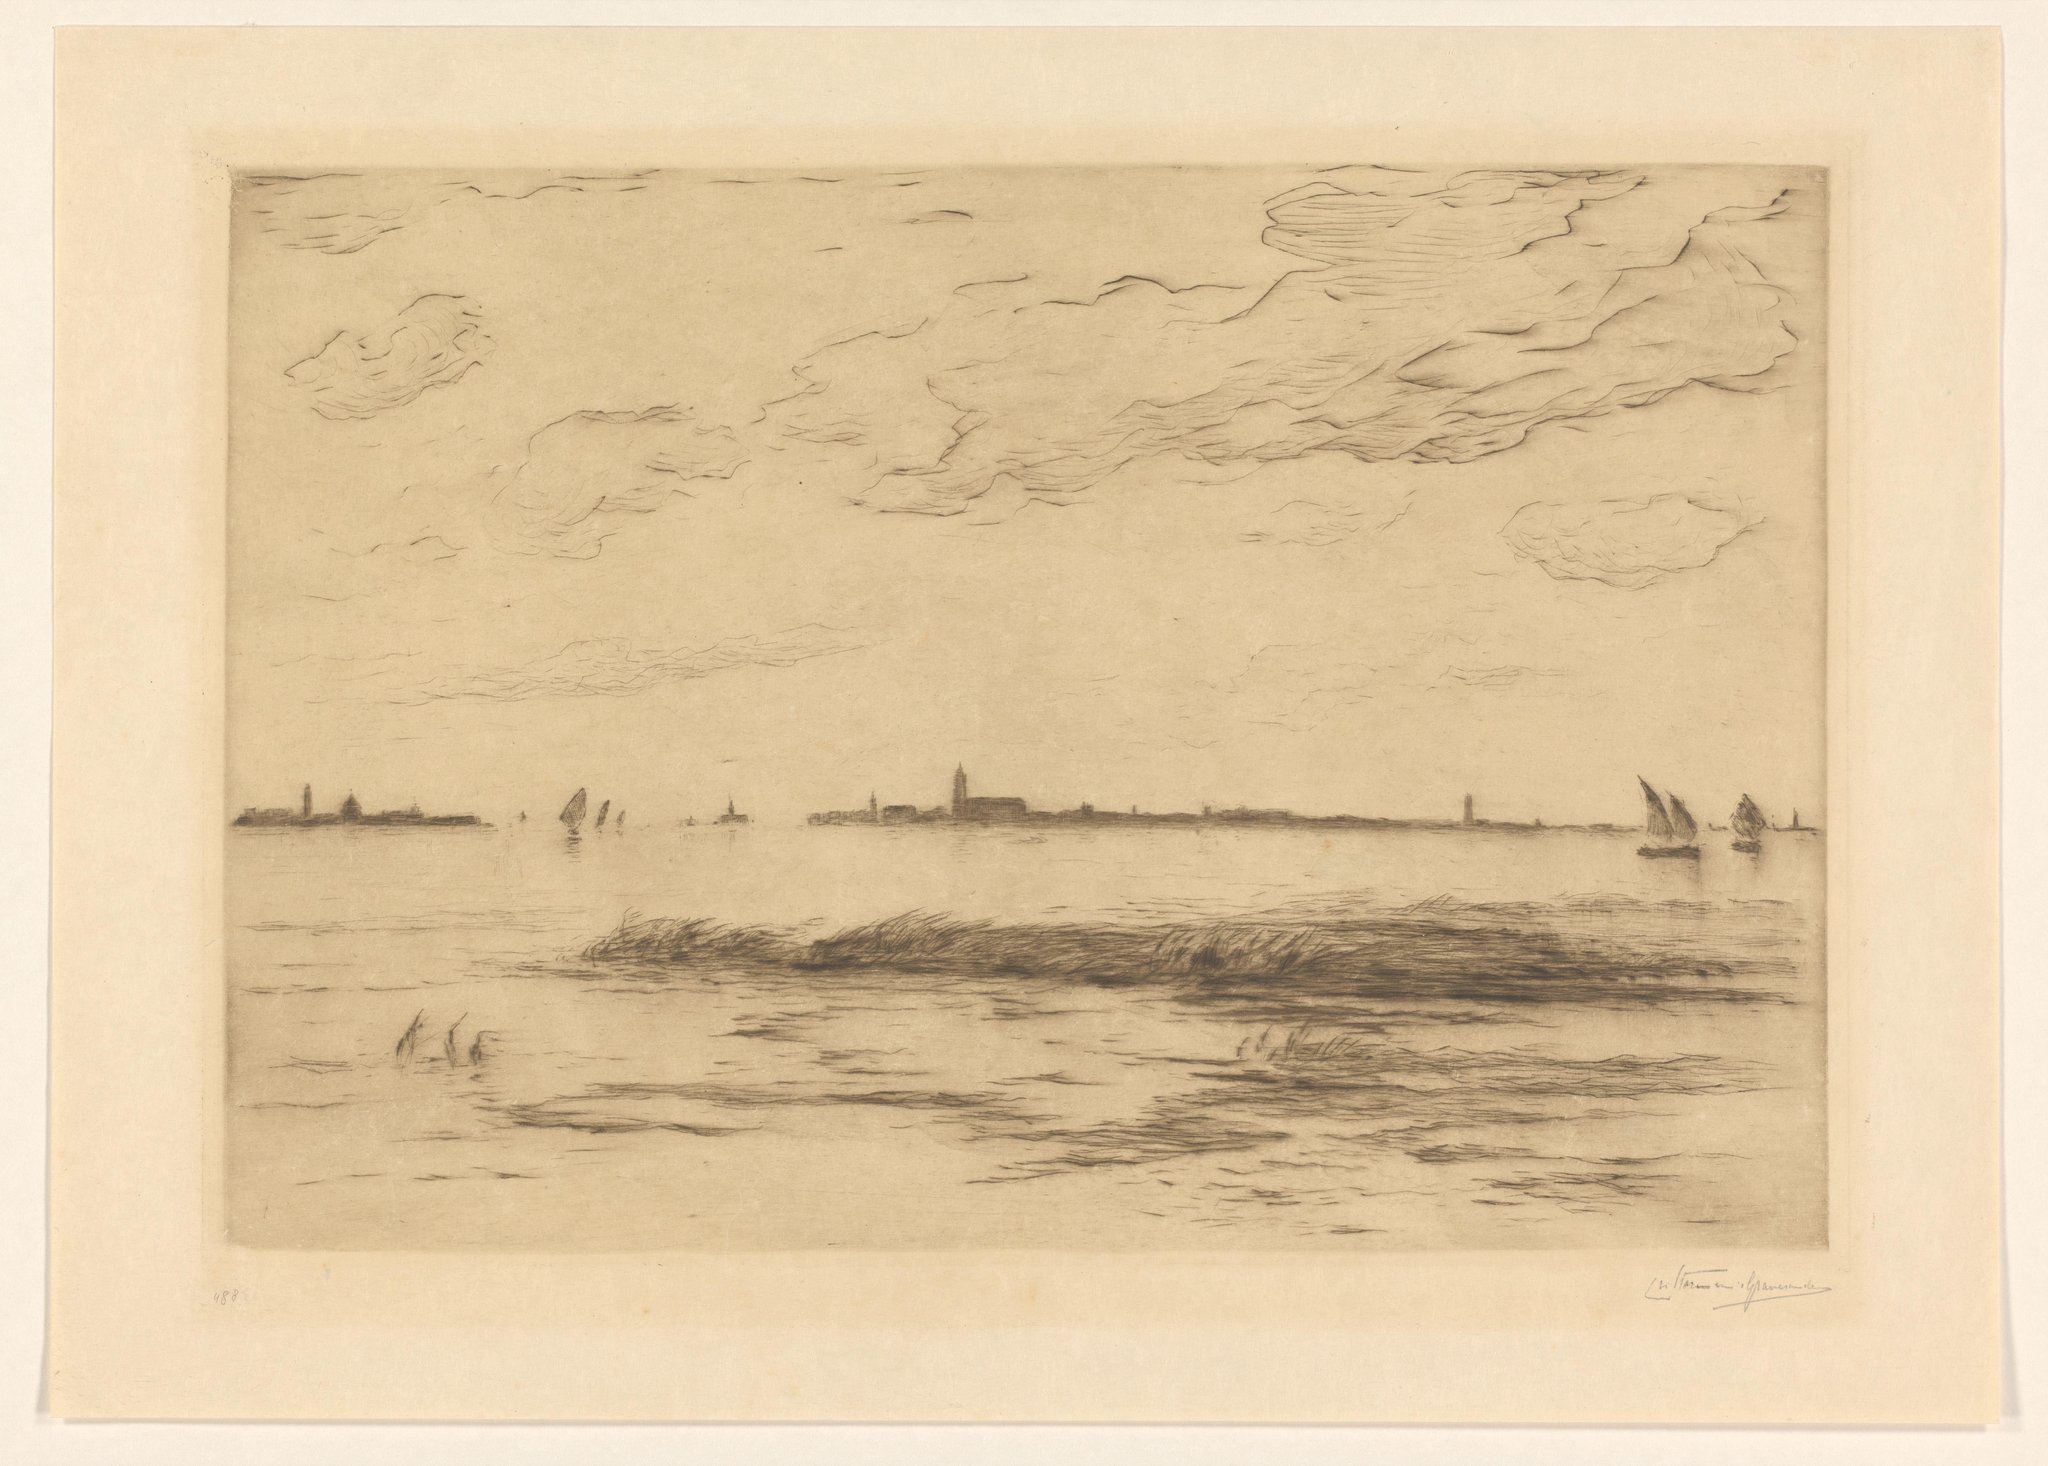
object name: print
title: Zeilboten op het water, in de verte een stad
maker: carel nicolaas storm van s-gravesande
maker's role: draughtsman, print maker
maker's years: 1841-1924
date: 1851-1924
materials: paper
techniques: drypoint, intaglio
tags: traffic on the water, prospect of city, town panorama, silhouette of city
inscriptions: collector's mark: Lugt 2760, collector's mark: Lugt 2228